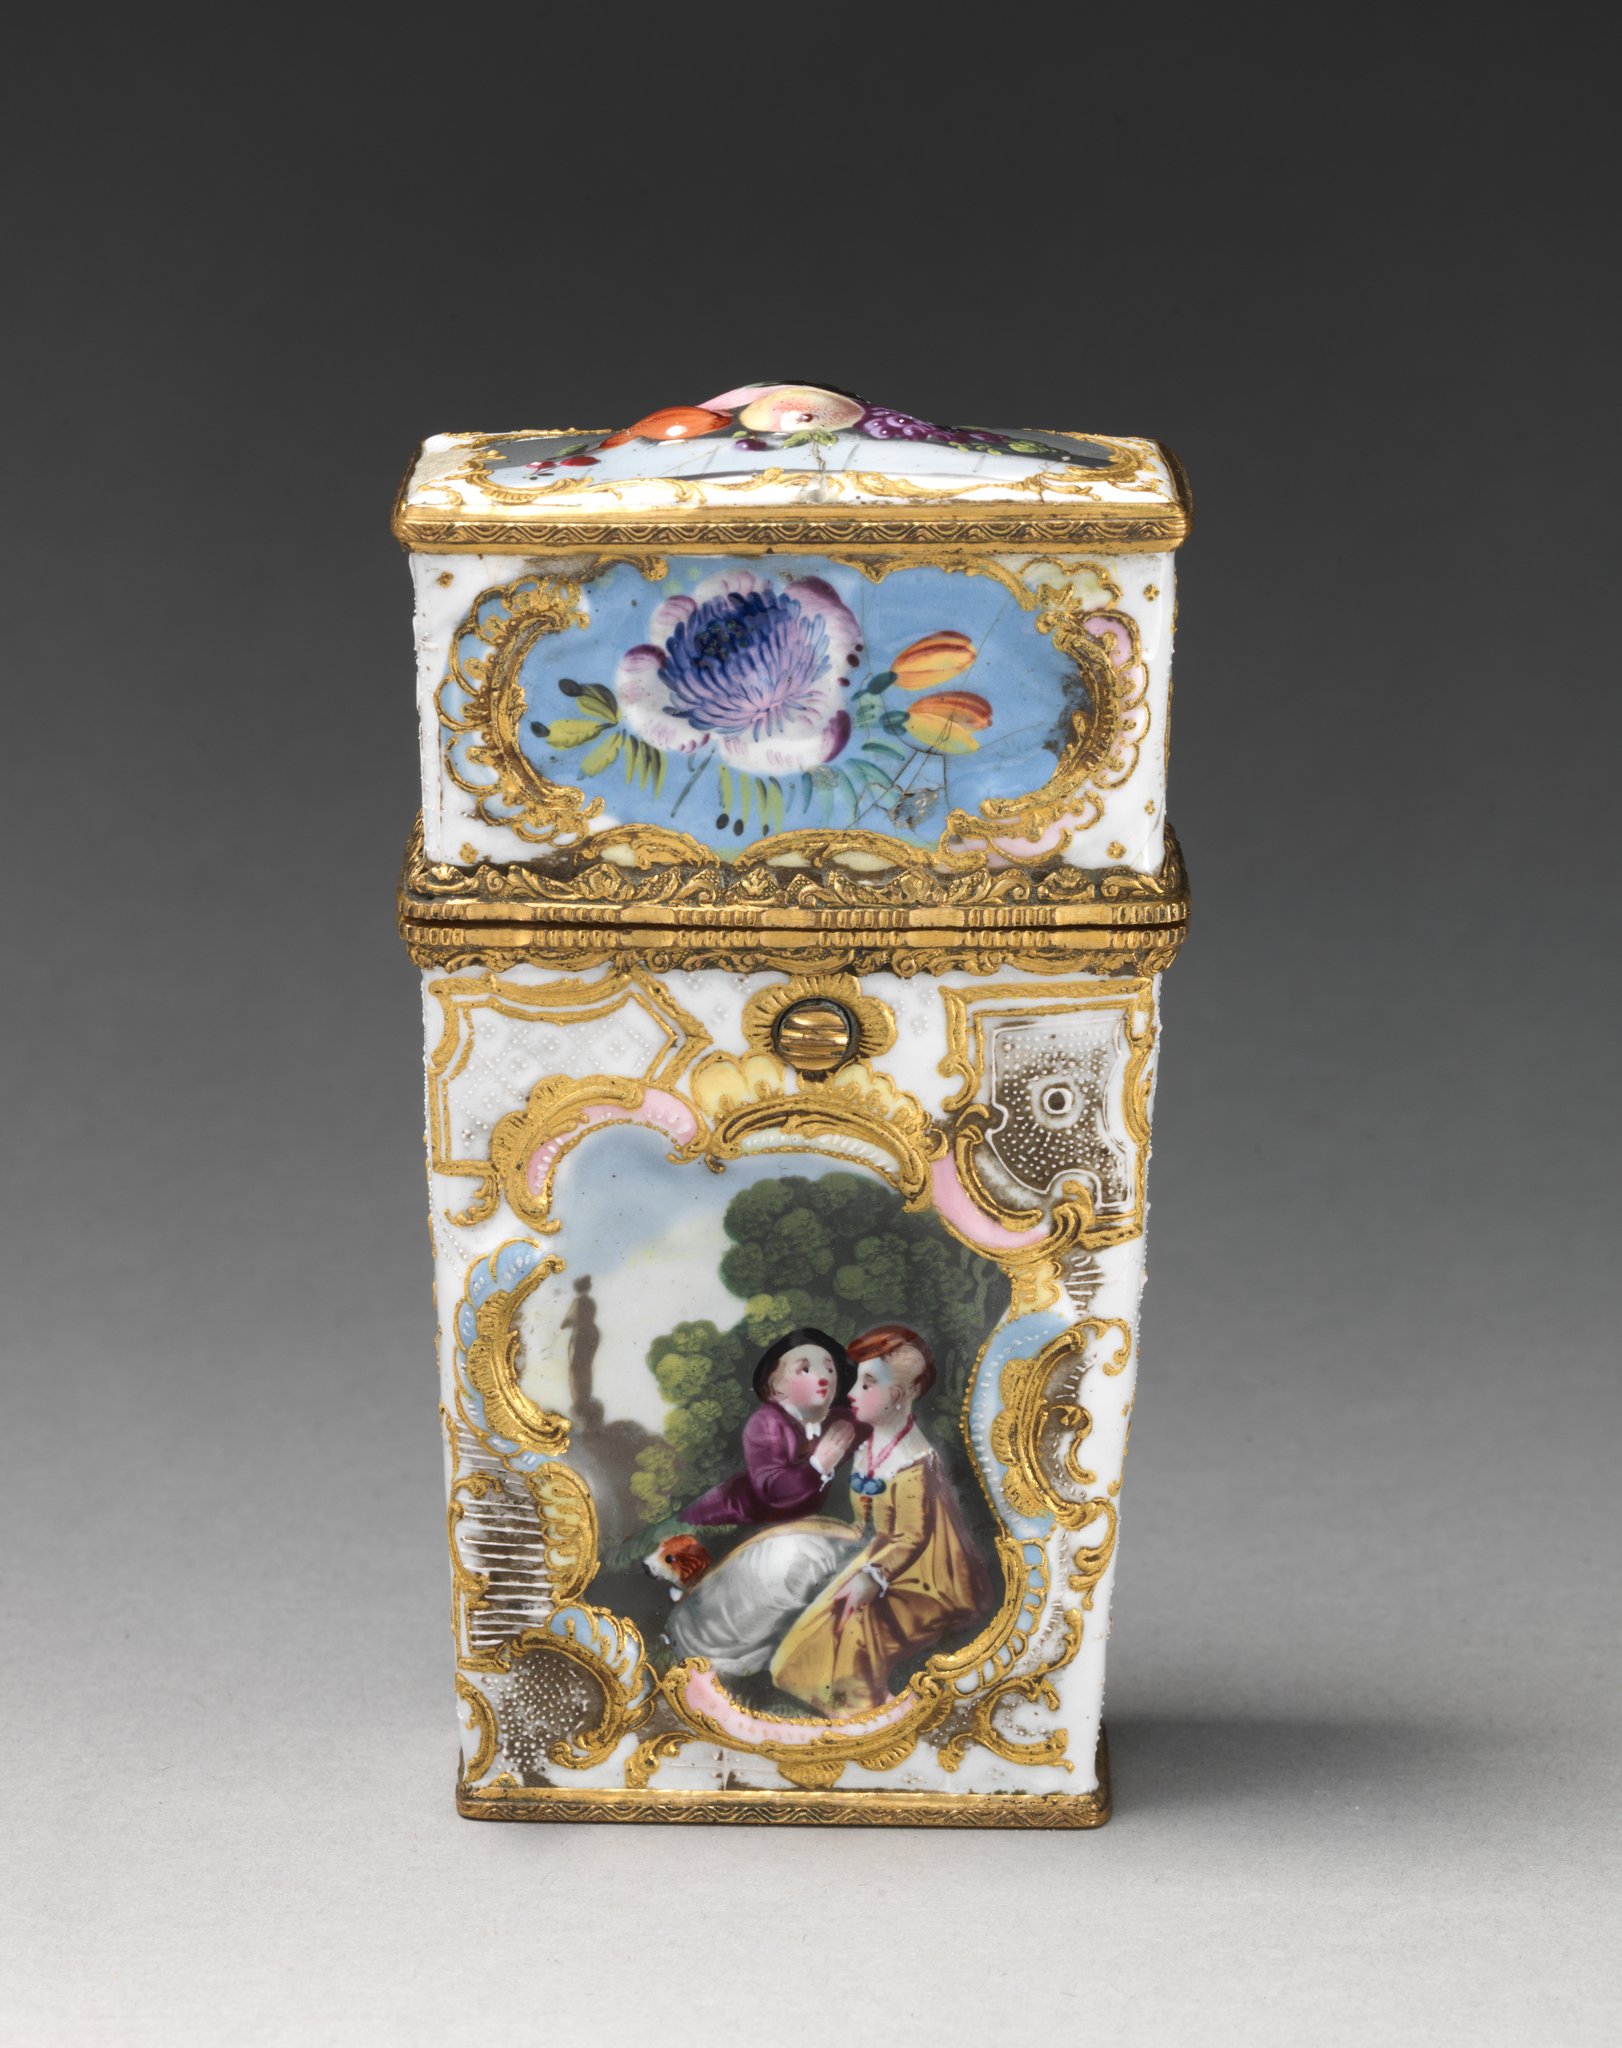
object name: étui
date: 1765-1770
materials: copper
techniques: enamel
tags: couples,flowers